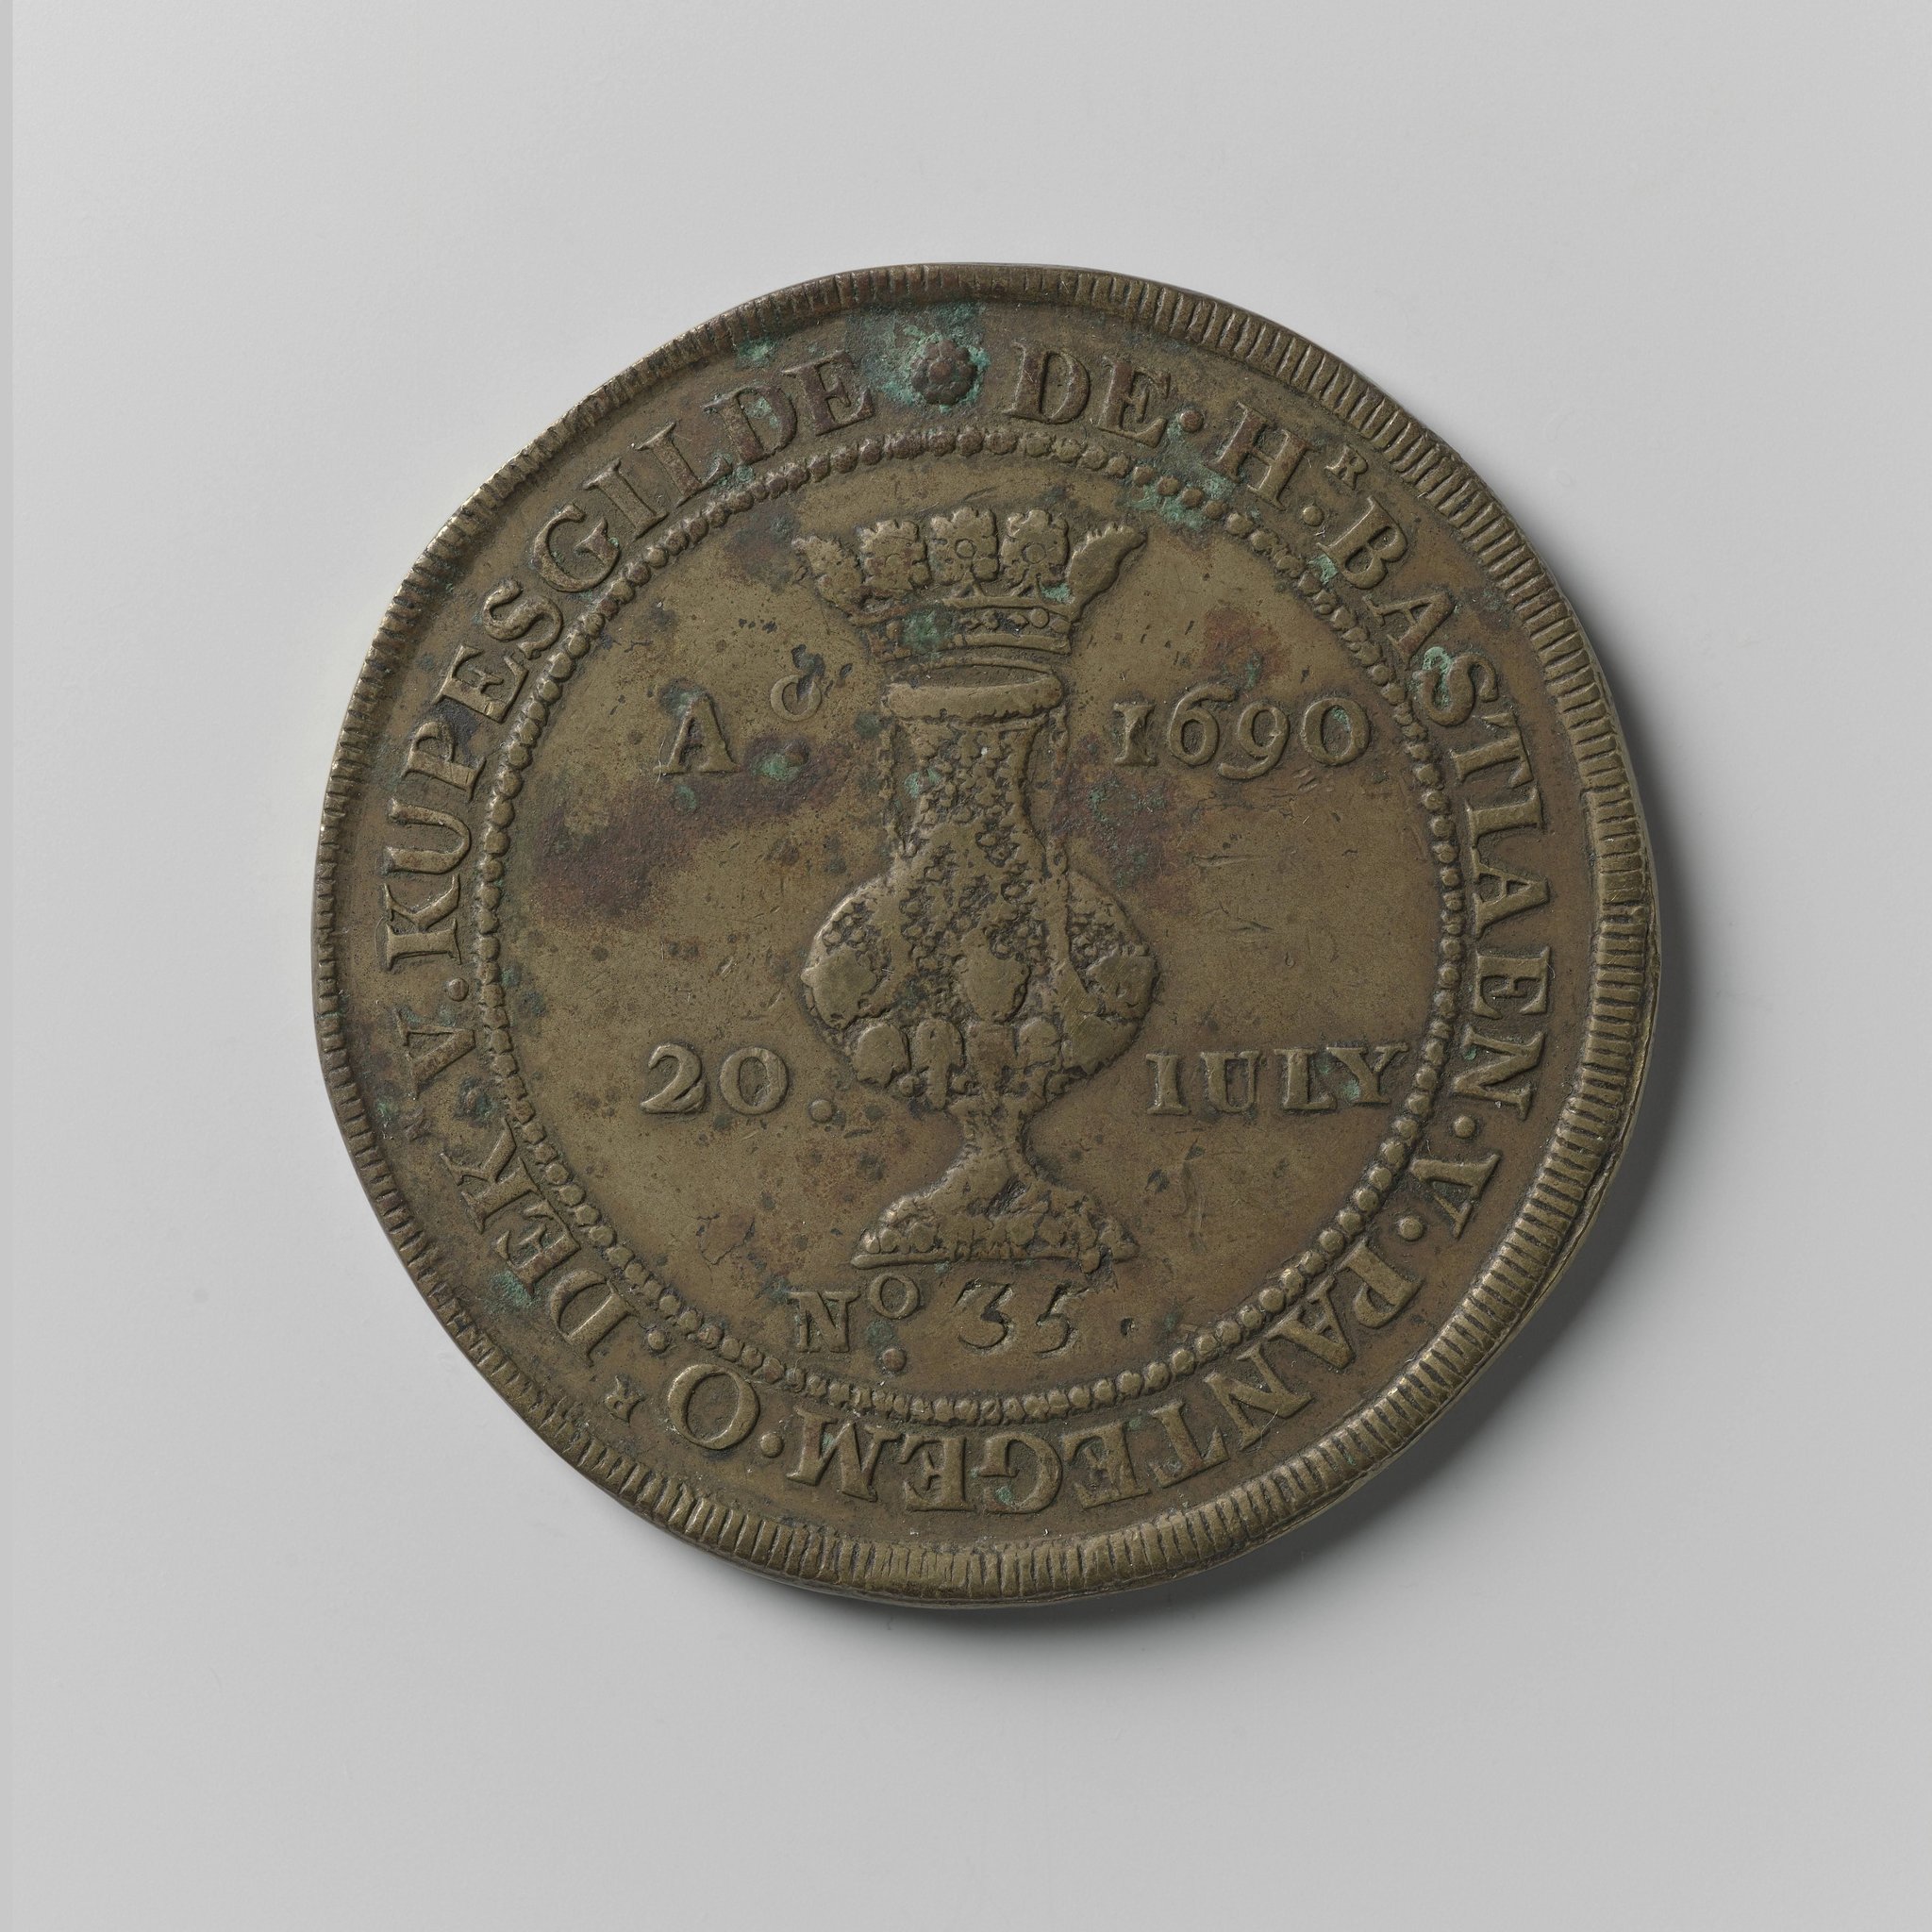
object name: medal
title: Kuipersgilde van Vlissingen, gildepenning met no. 35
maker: Anonymous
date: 1690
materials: brass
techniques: engraving, striking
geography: flushing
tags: flushing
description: Messing penning. Voorzijde: gekroonde fles tussen jaartal en datering boven opschrift No. 35 binnen omschrift. Keerzijde: kuipersdissel; in boog van dissel en er onder: andere kuiperswerktuigen en drie tonnen binnen omschrift